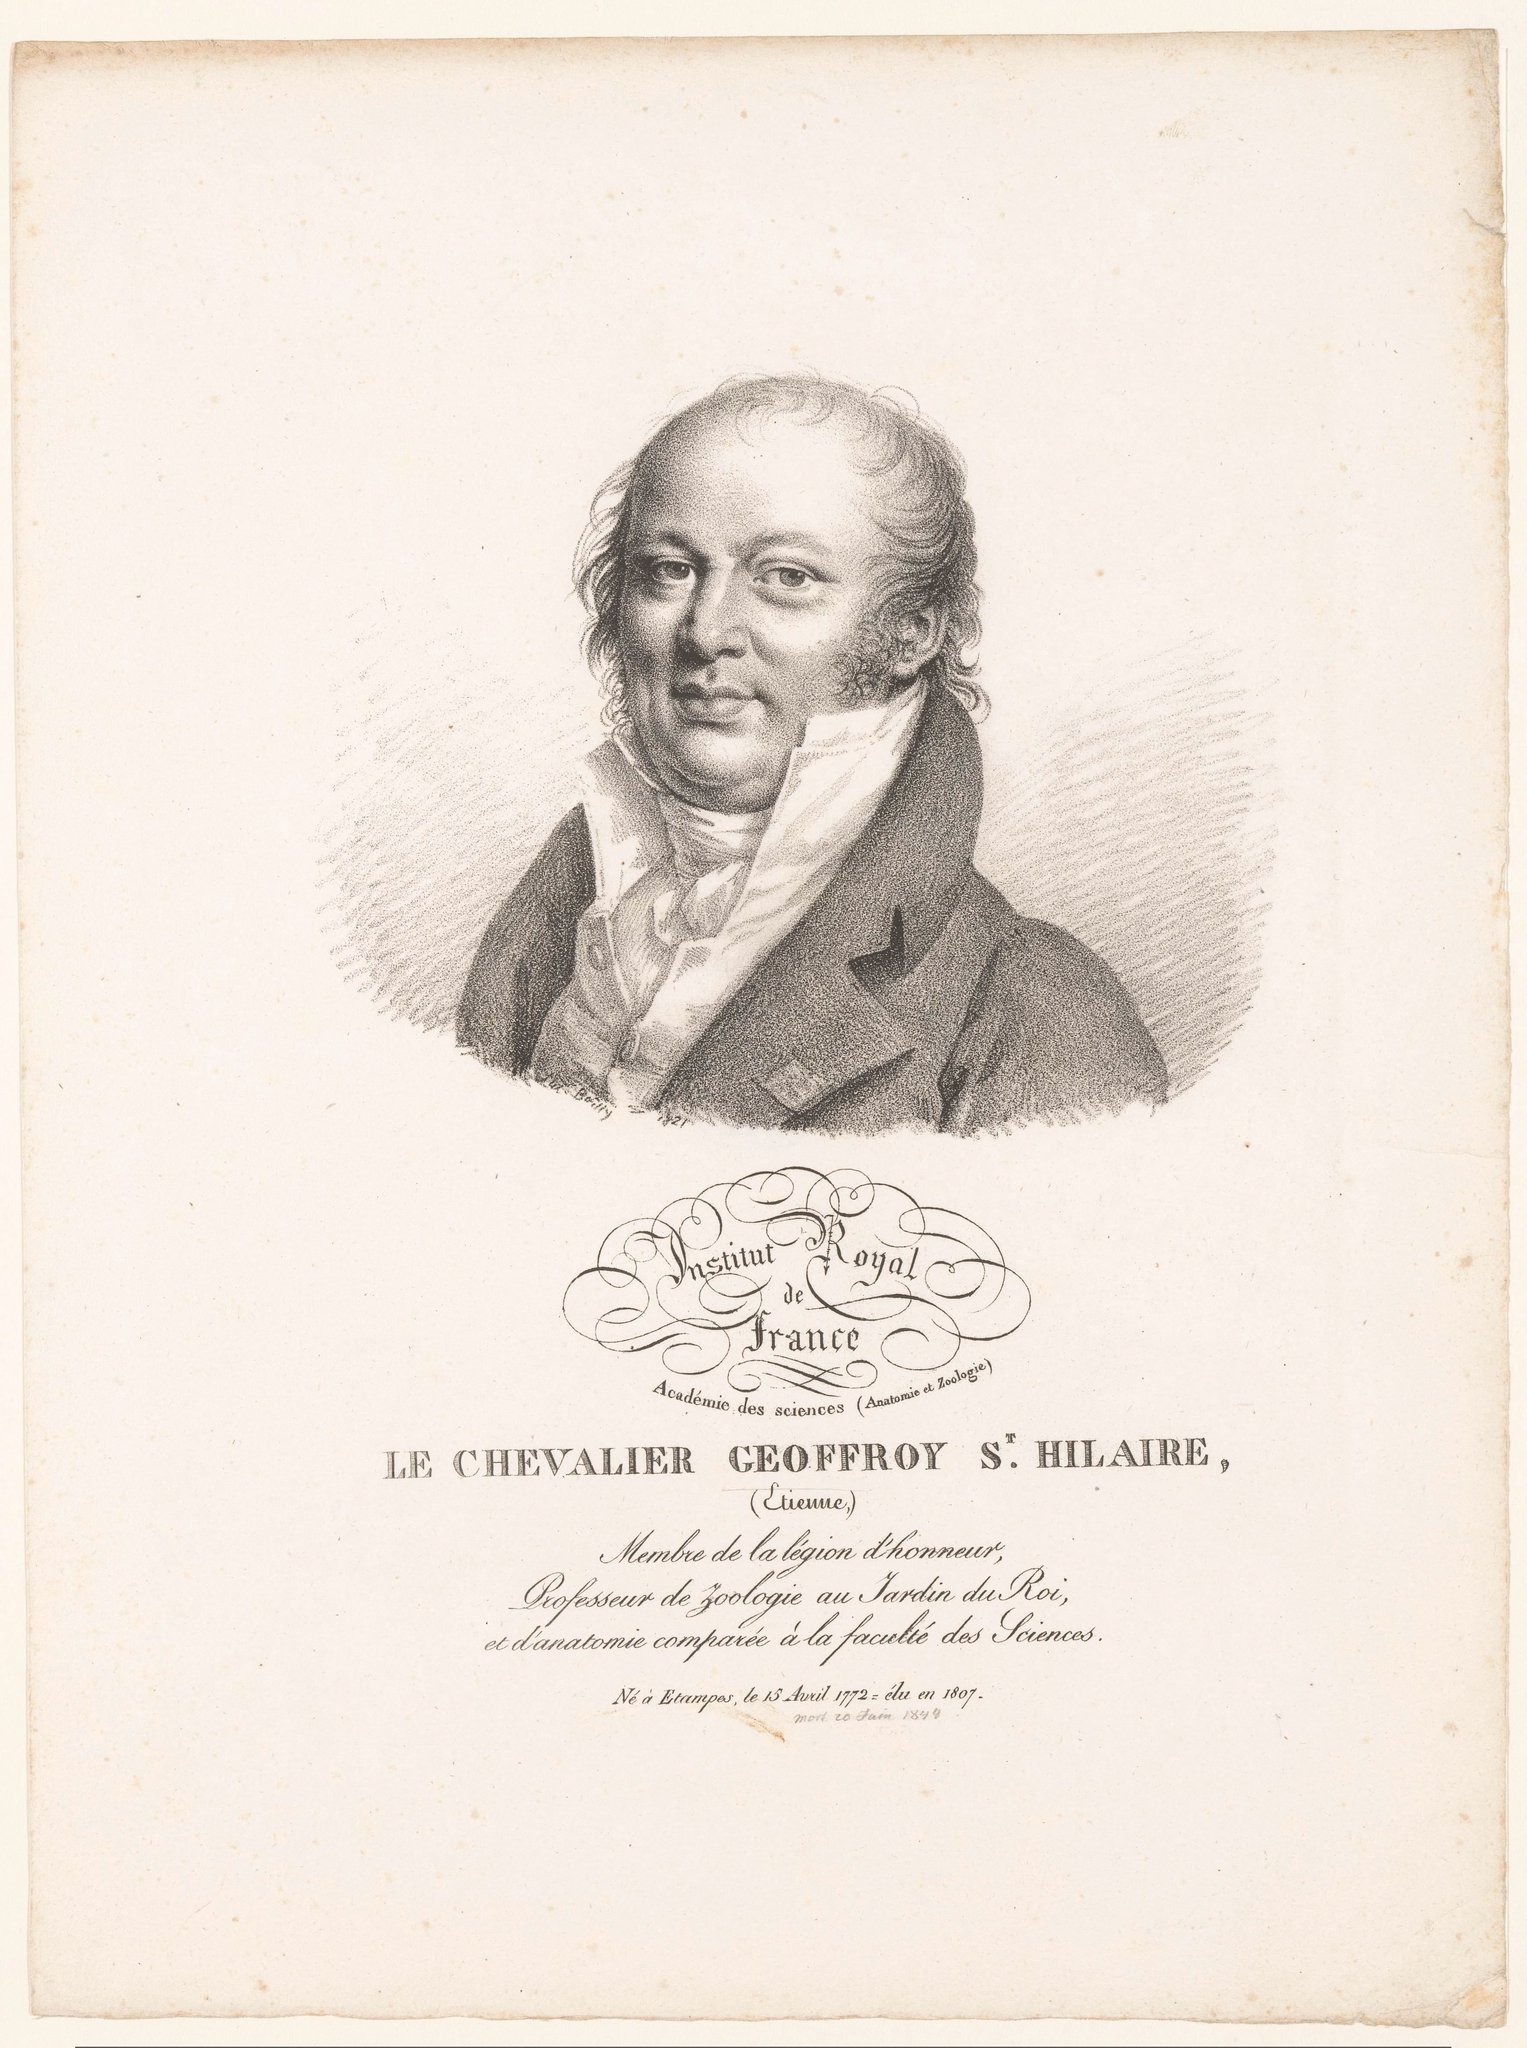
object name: print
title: Iconographie de l'Institut Royal de France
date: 1821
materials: paper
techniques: lithograph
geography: paris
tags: paris, physicist, historical persons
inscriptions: collector's mark: Lugt 2228a